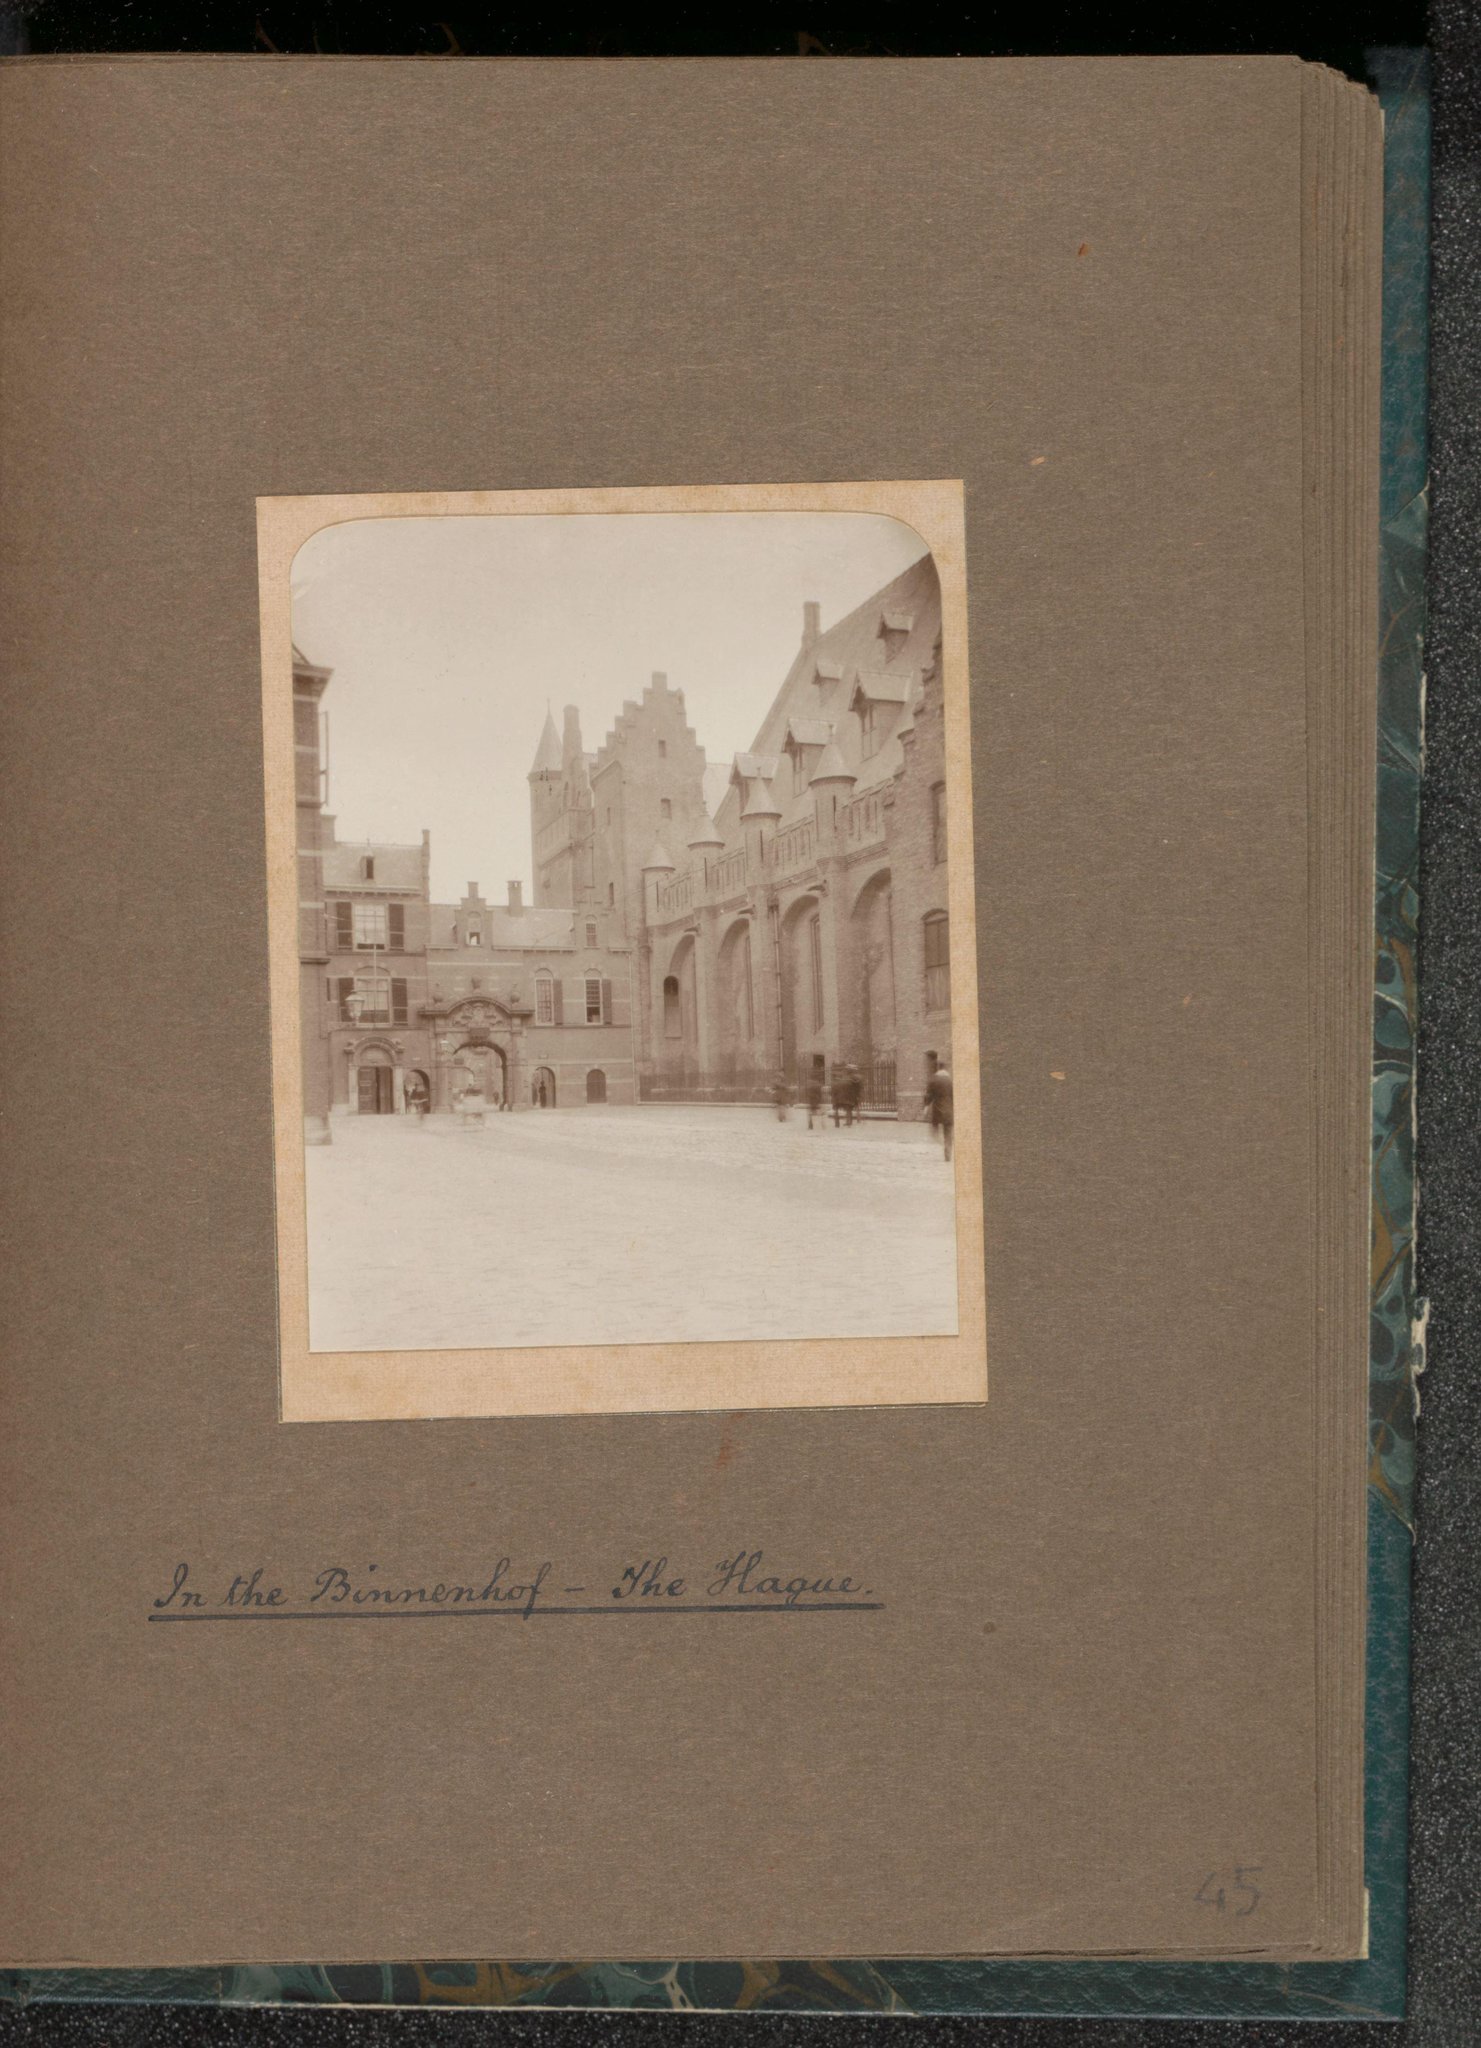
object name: photograph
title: Binnenplaats van het Binnenhof in Den Haag, gezien richting Mauritspoort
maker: Anonymous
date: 1912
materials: photographic support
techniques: gelatin silver print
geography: the hague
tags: travelling; tourism, courtyard, the hague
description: Onderdeel van Fotoalbum van de excursie naar Nederland van de Britse amateurfotografenvereniging P.C.U.K.